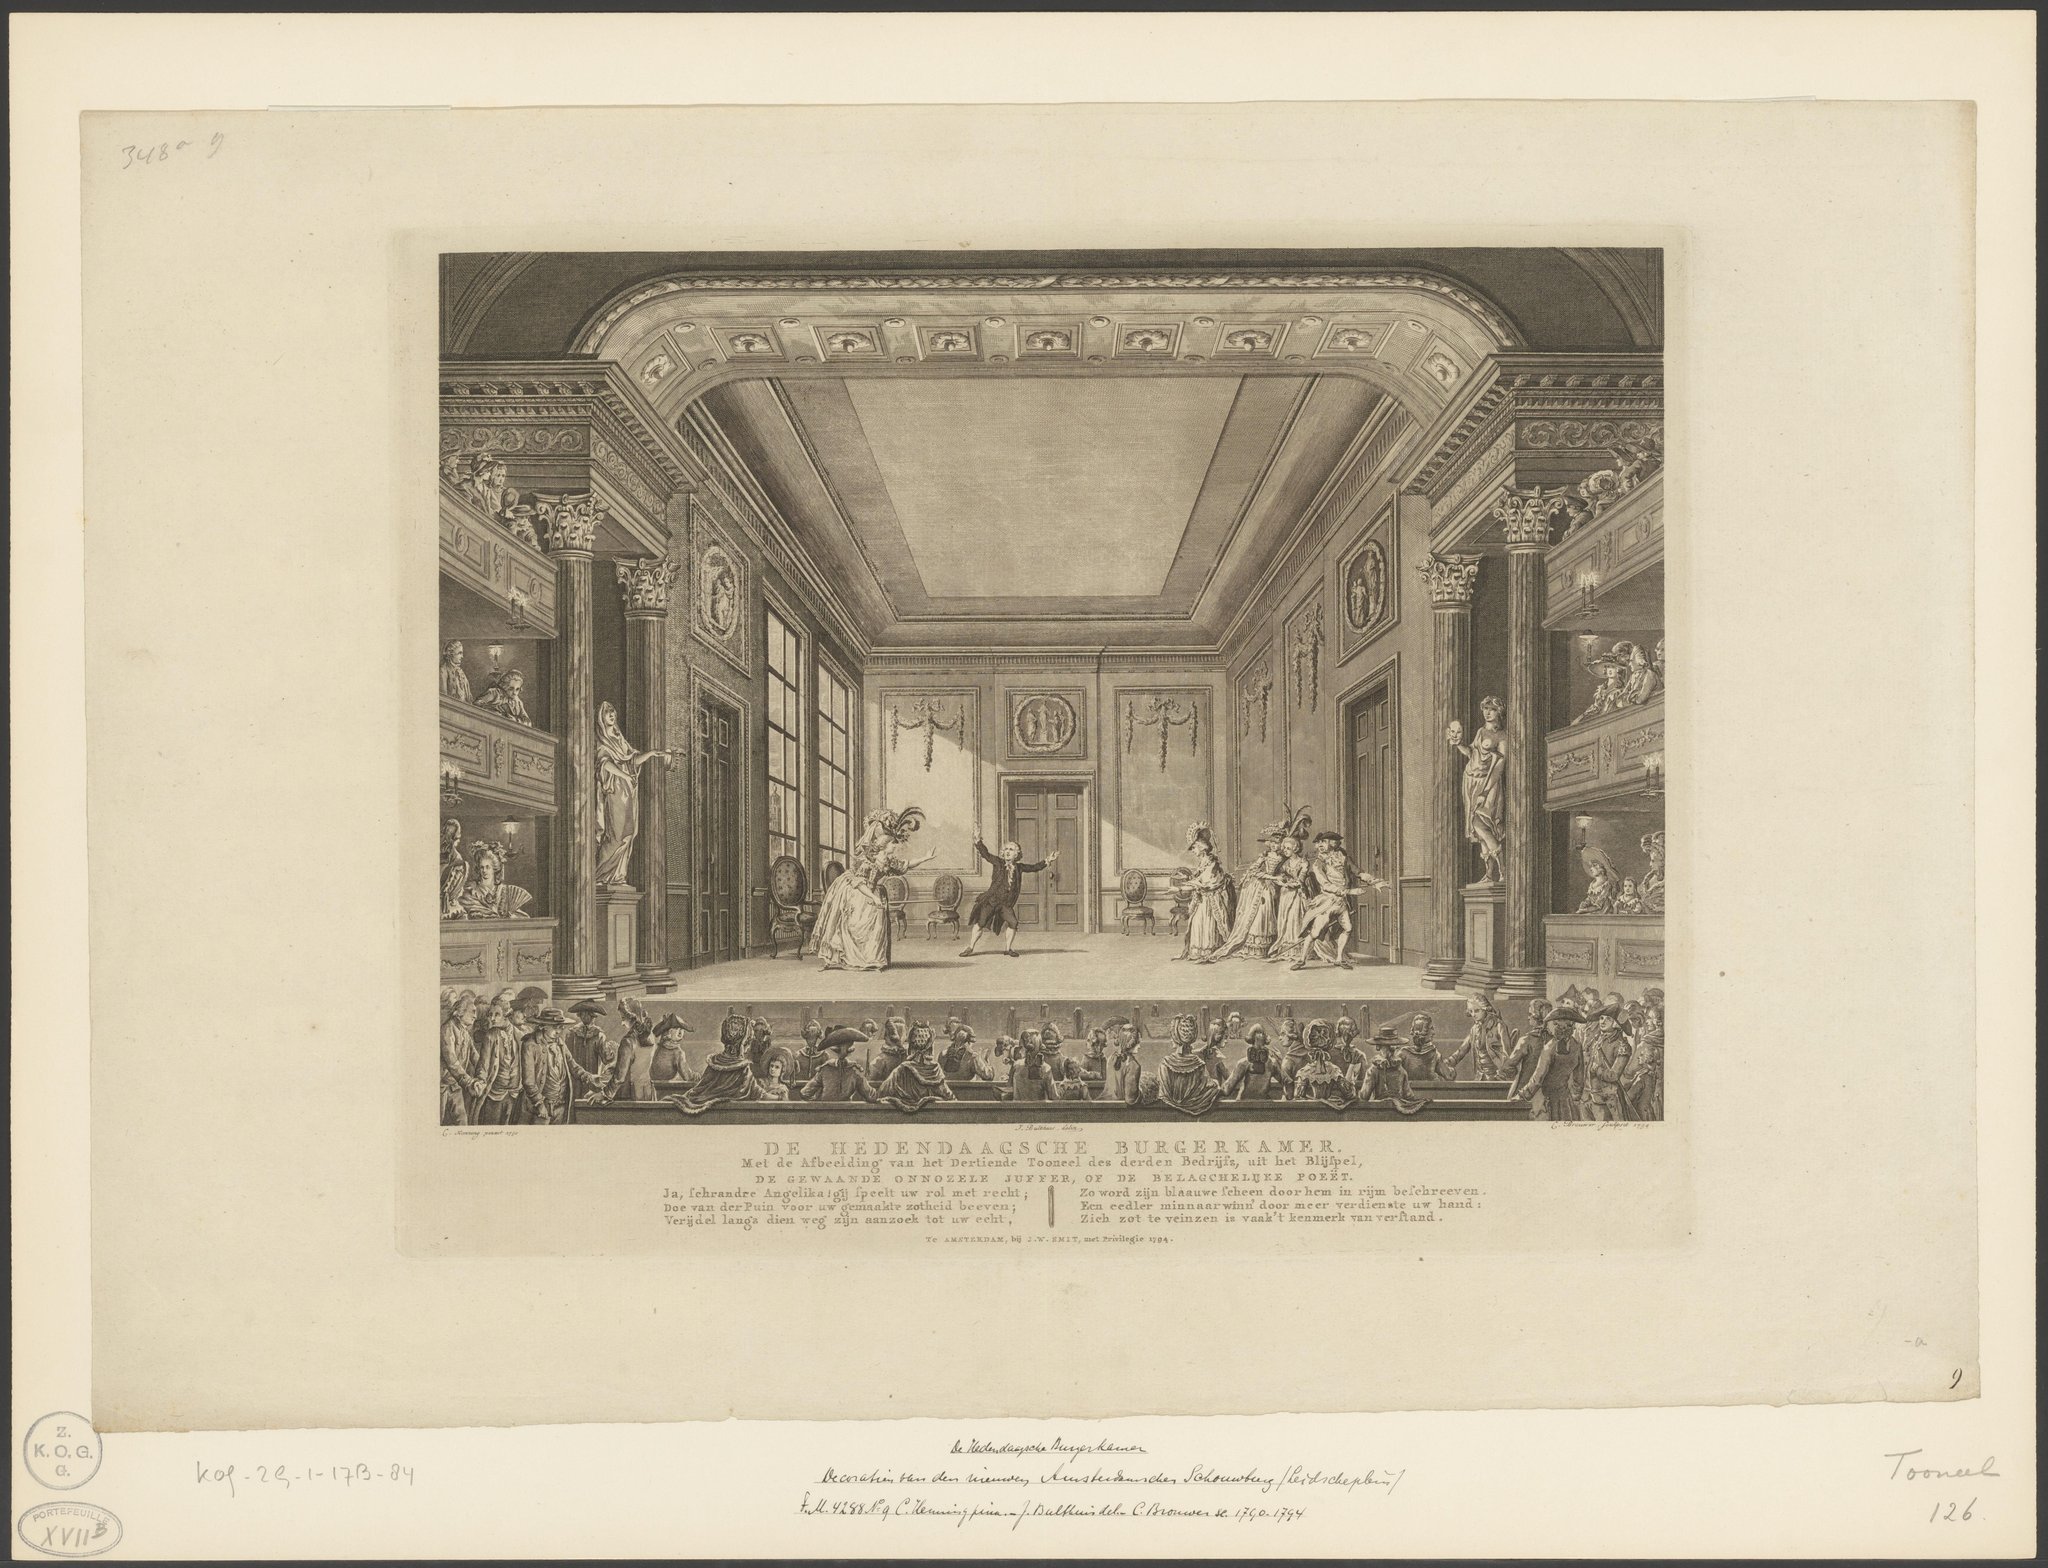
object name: print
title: Schouwburg met toneeldecor: De Hedendaagsche Burgerkamer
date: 1794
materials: paper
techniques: engraving, etching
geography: amsterdam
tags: theatre, theatrical performance, stage design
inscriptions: collector's mark: Lugt 1641, stamp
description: Toneelvoorstelling in de nieuwe Amsterdamse Schouwburg met het coulissendecor De Hedendaagsche Burgerkamer, met scène uit De stiefmoer Kluchtspel. Het decor gedrukt van een aparte plaat binnen een passe-partout met de zaal, zijloges, pilaren met standbeelden en de façade van het toneel. In het onderschrift een zesregelig vers. Onderdeel van de serie van veertien toneeldecors van de nieuwe Amsterdamse Schouwburg, 1787-1794. Onderwerpsrubrieken binnen de Atlas Zeden en Gewoonten: Schoone kunsten, Tooneel, Decors voor de Schouwburg.